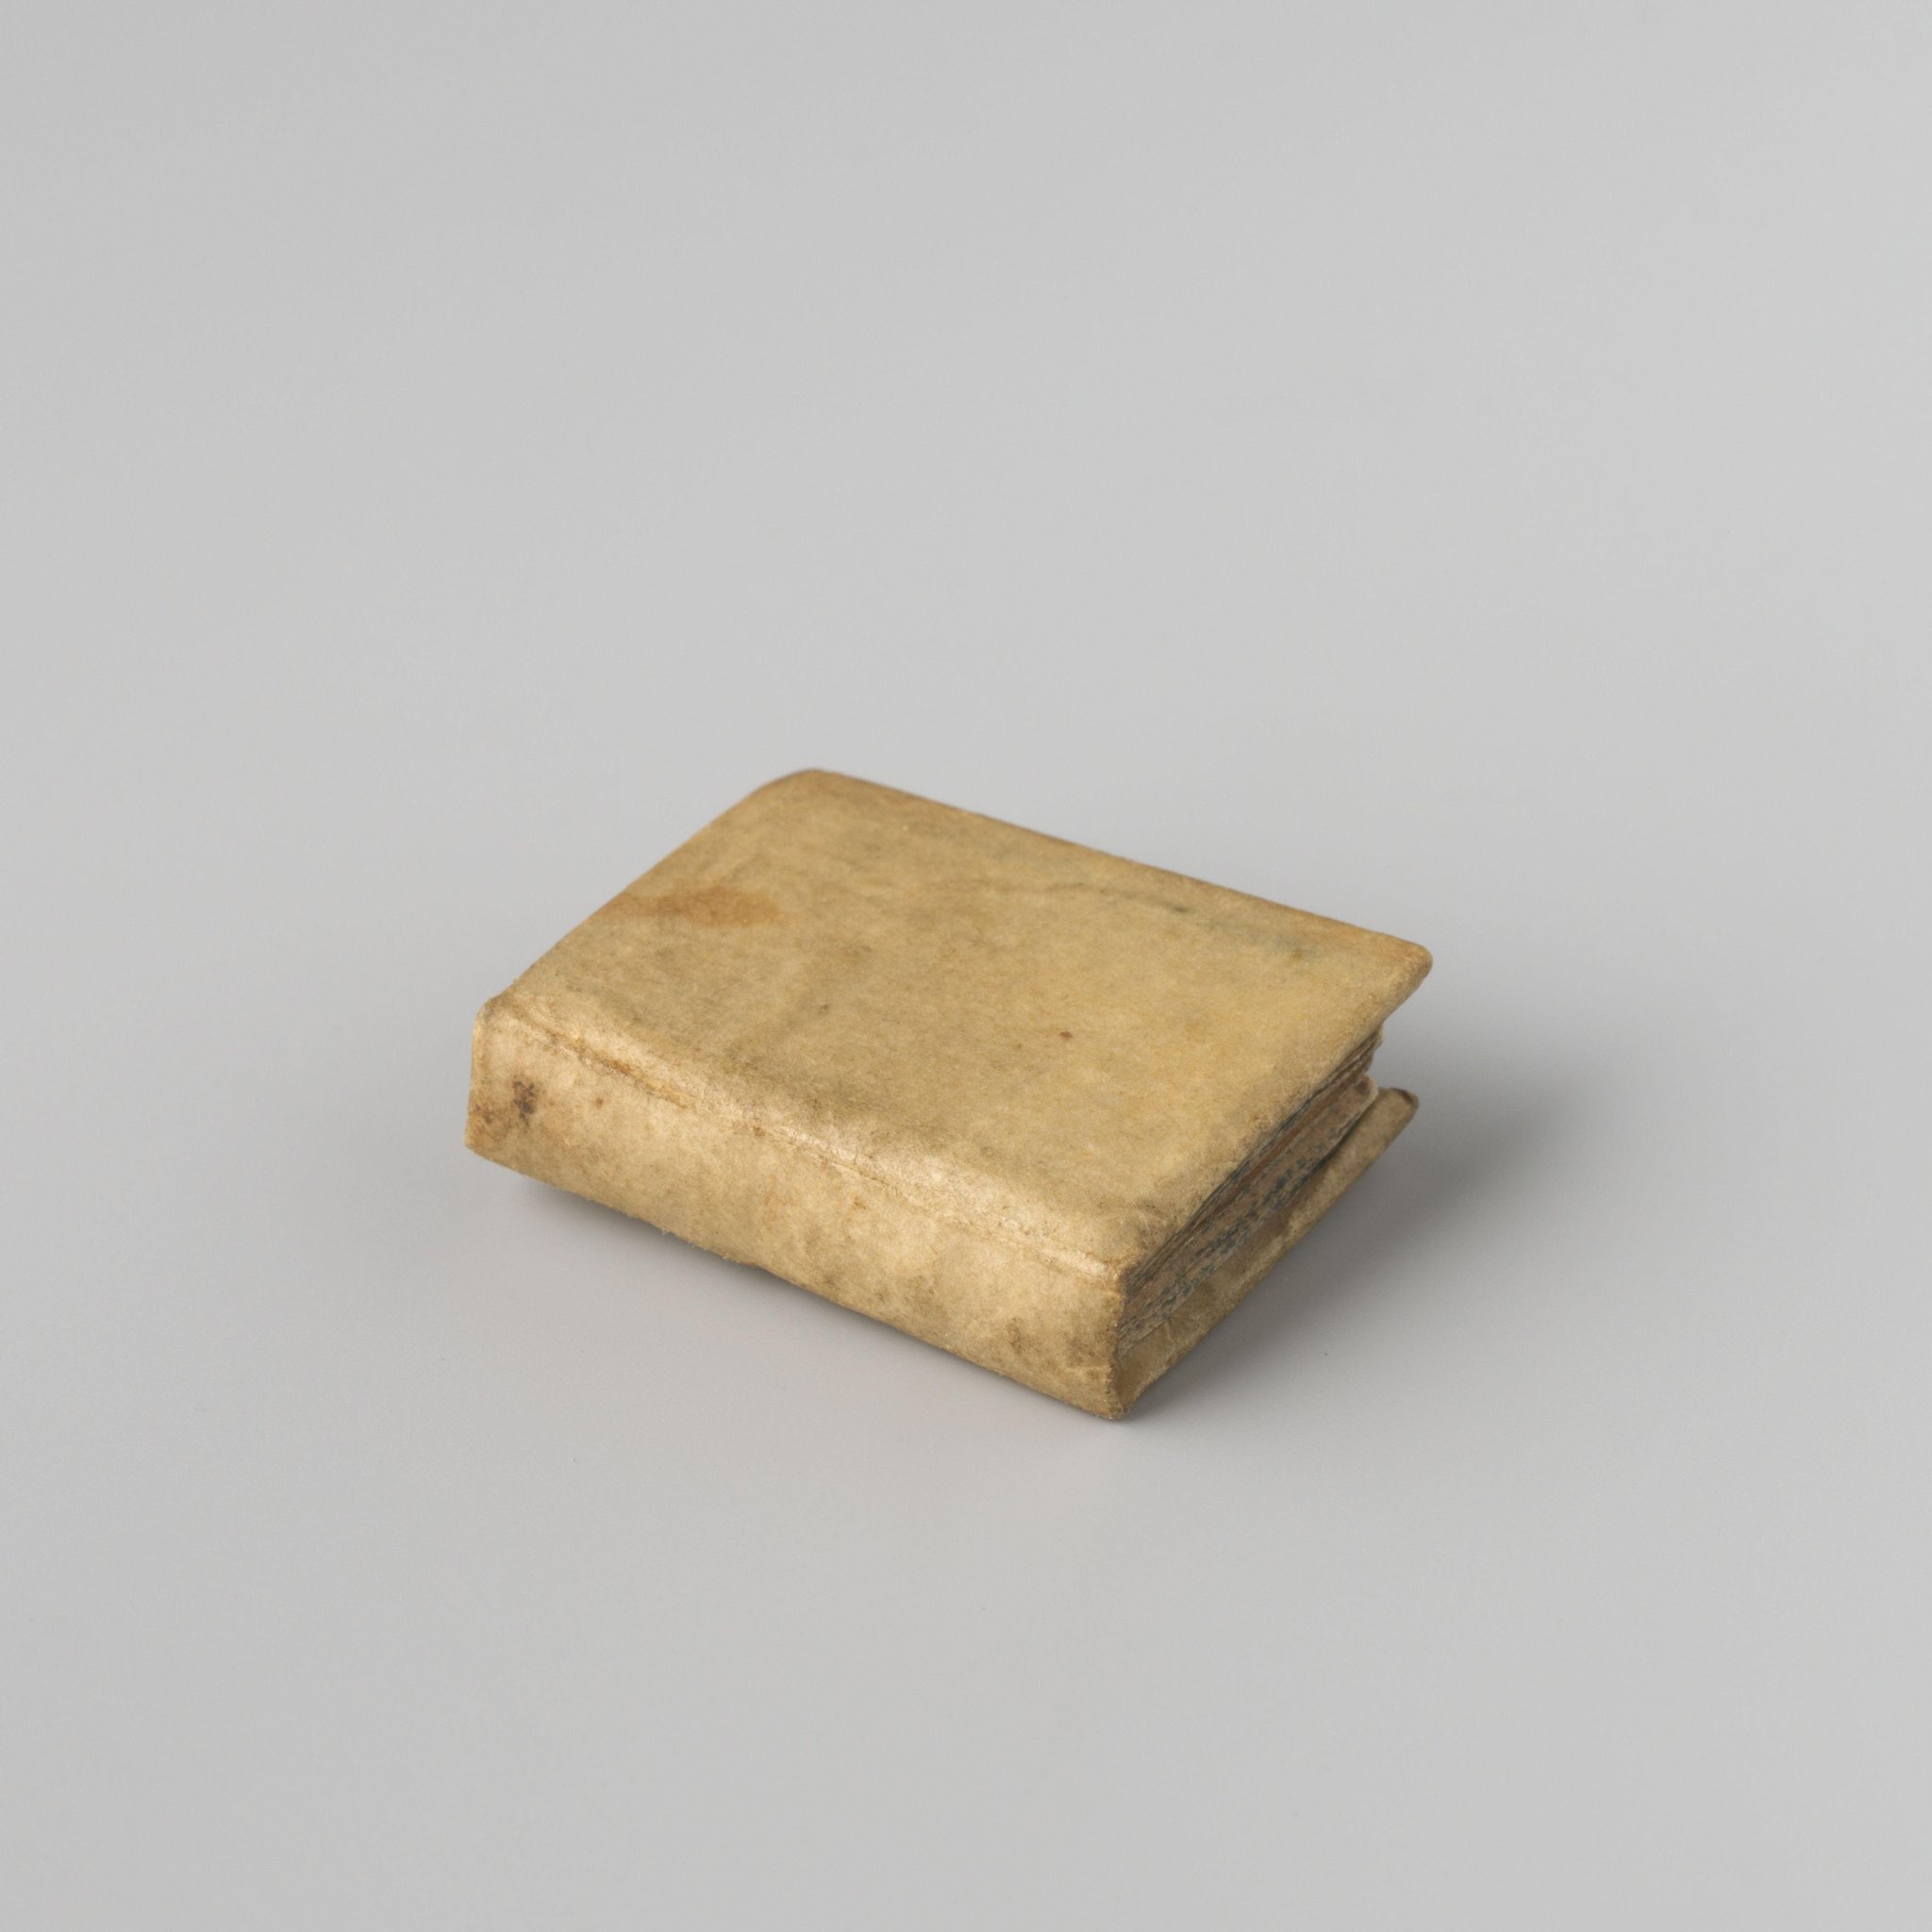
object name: book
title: Boek met legeropstellingen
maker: Anonymous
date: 1690-1710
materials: paper, parchment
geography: amsterdam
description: Boek met legeropstellingen. Ingebonden in blank perkament.